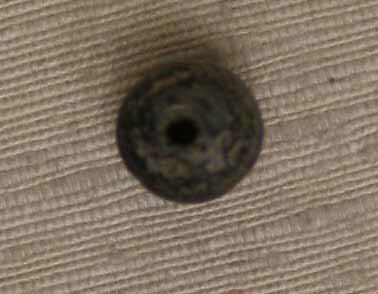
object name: bead and pendant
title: Beads and Pendants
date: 701-1300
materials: stone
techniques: cutting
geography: iran